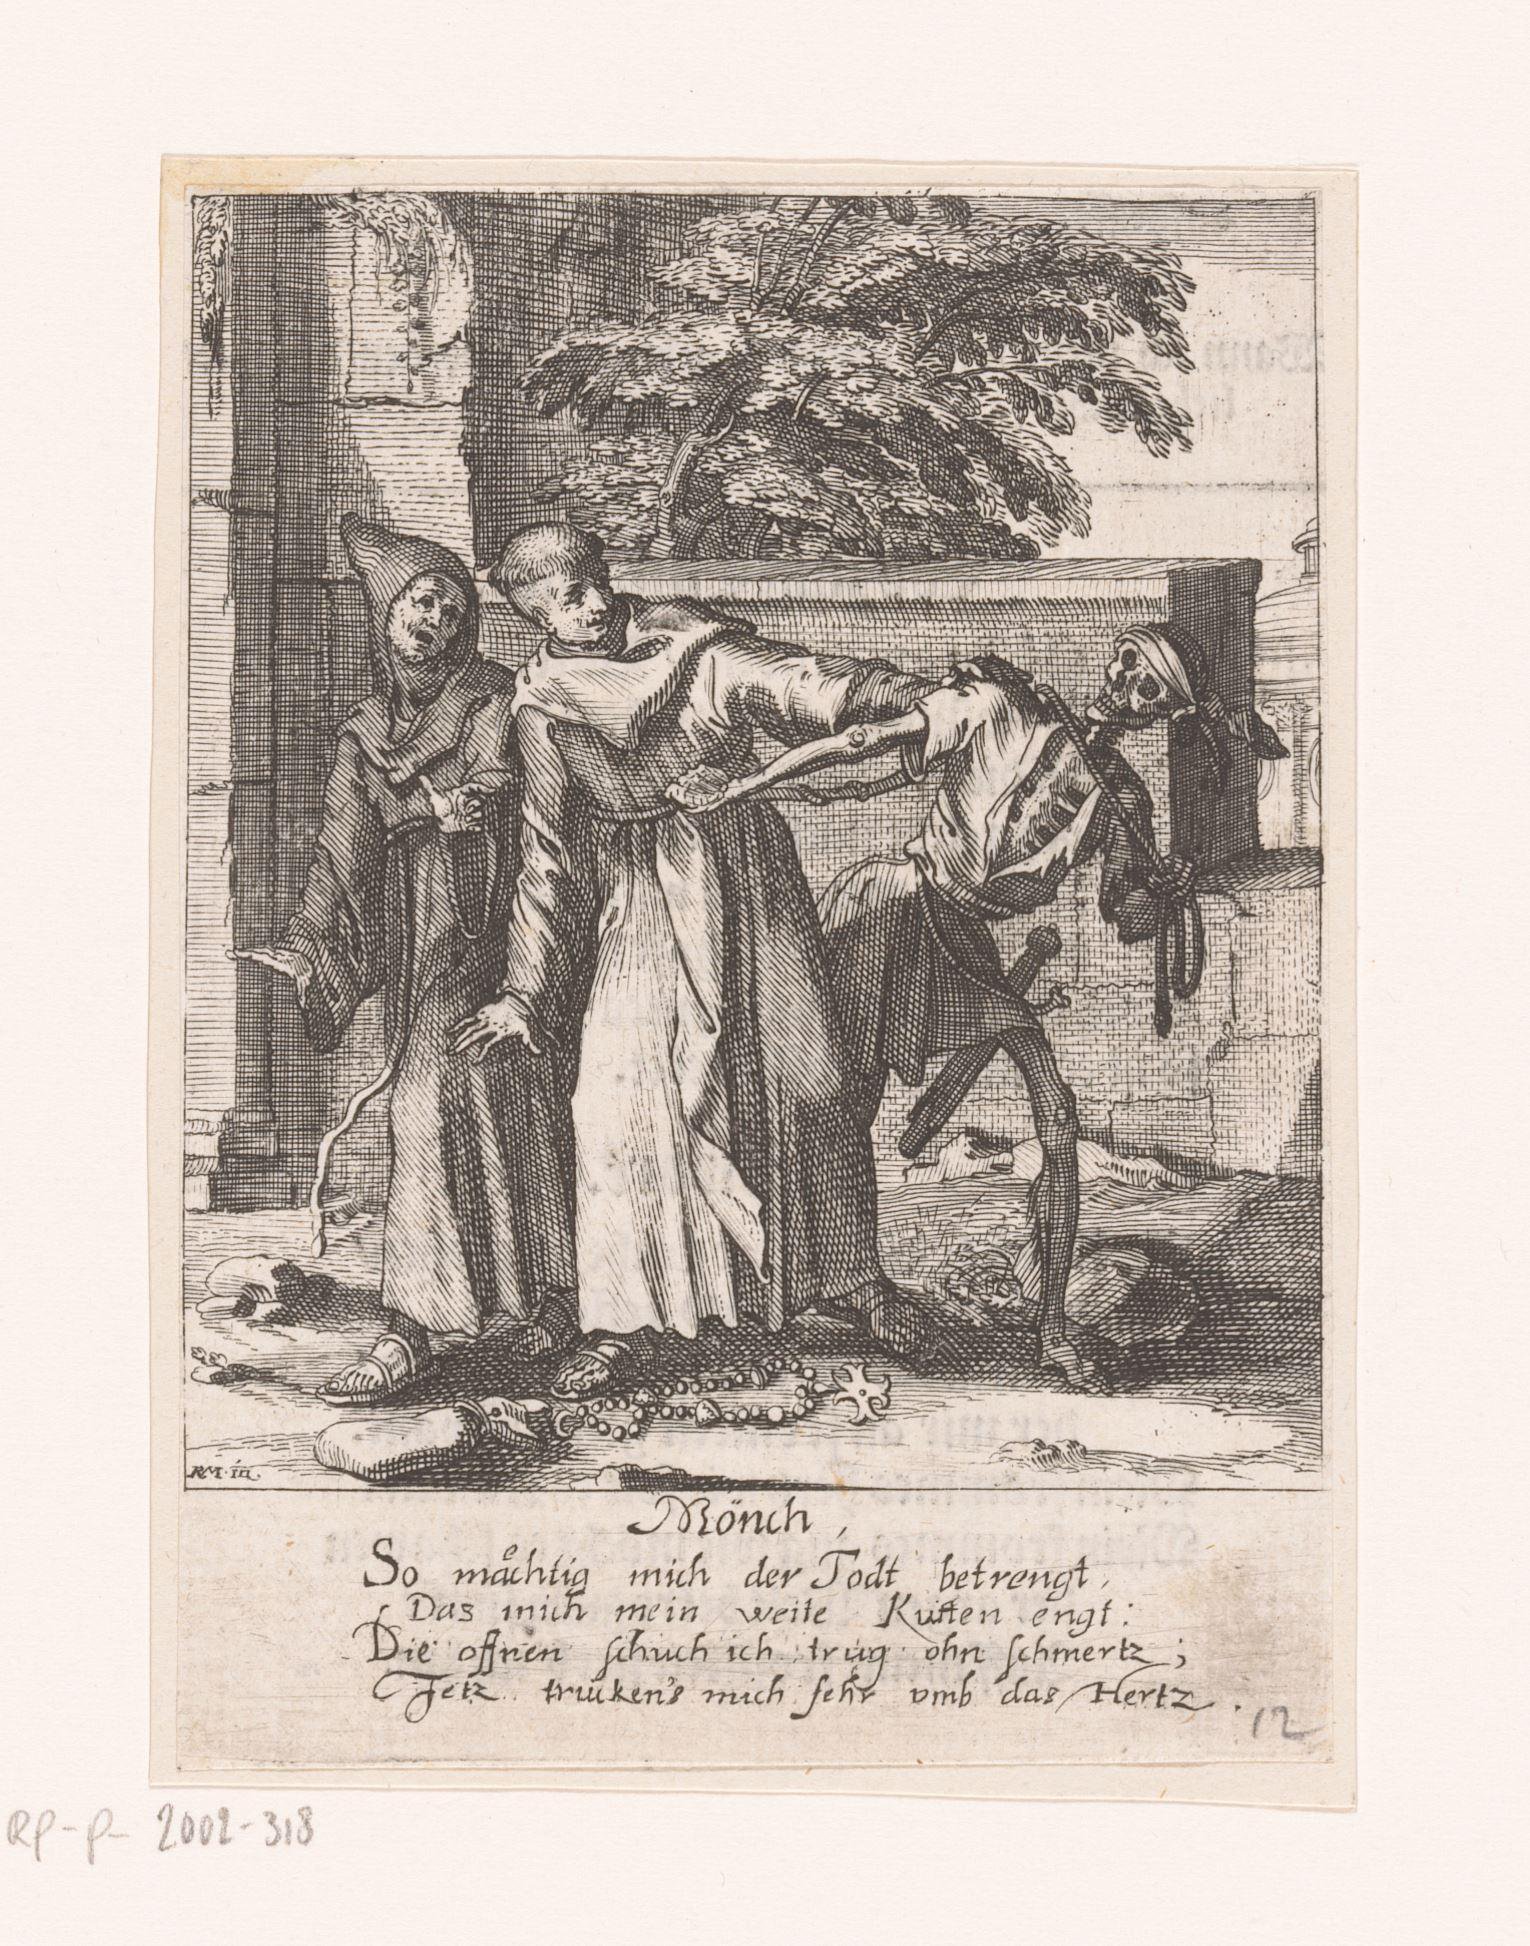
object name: book illustration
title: Monnik en de Dood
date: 1650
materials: paper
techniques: etching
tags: abbot, personifications of death; 'morte' (ripa), dance of death; death together with one or more human beings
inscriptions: collector's mark: Lugt 2228, collector's mark: Lugt 2233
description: Prent uit: Meyer, Rudolph. Sterbenspiegel, das ist sonnenklare Vorstellung menschlicher Nichtigkeit durch alle Ständ und Geschlechter (...). Zürich: J.J. Bodmer, 1650.